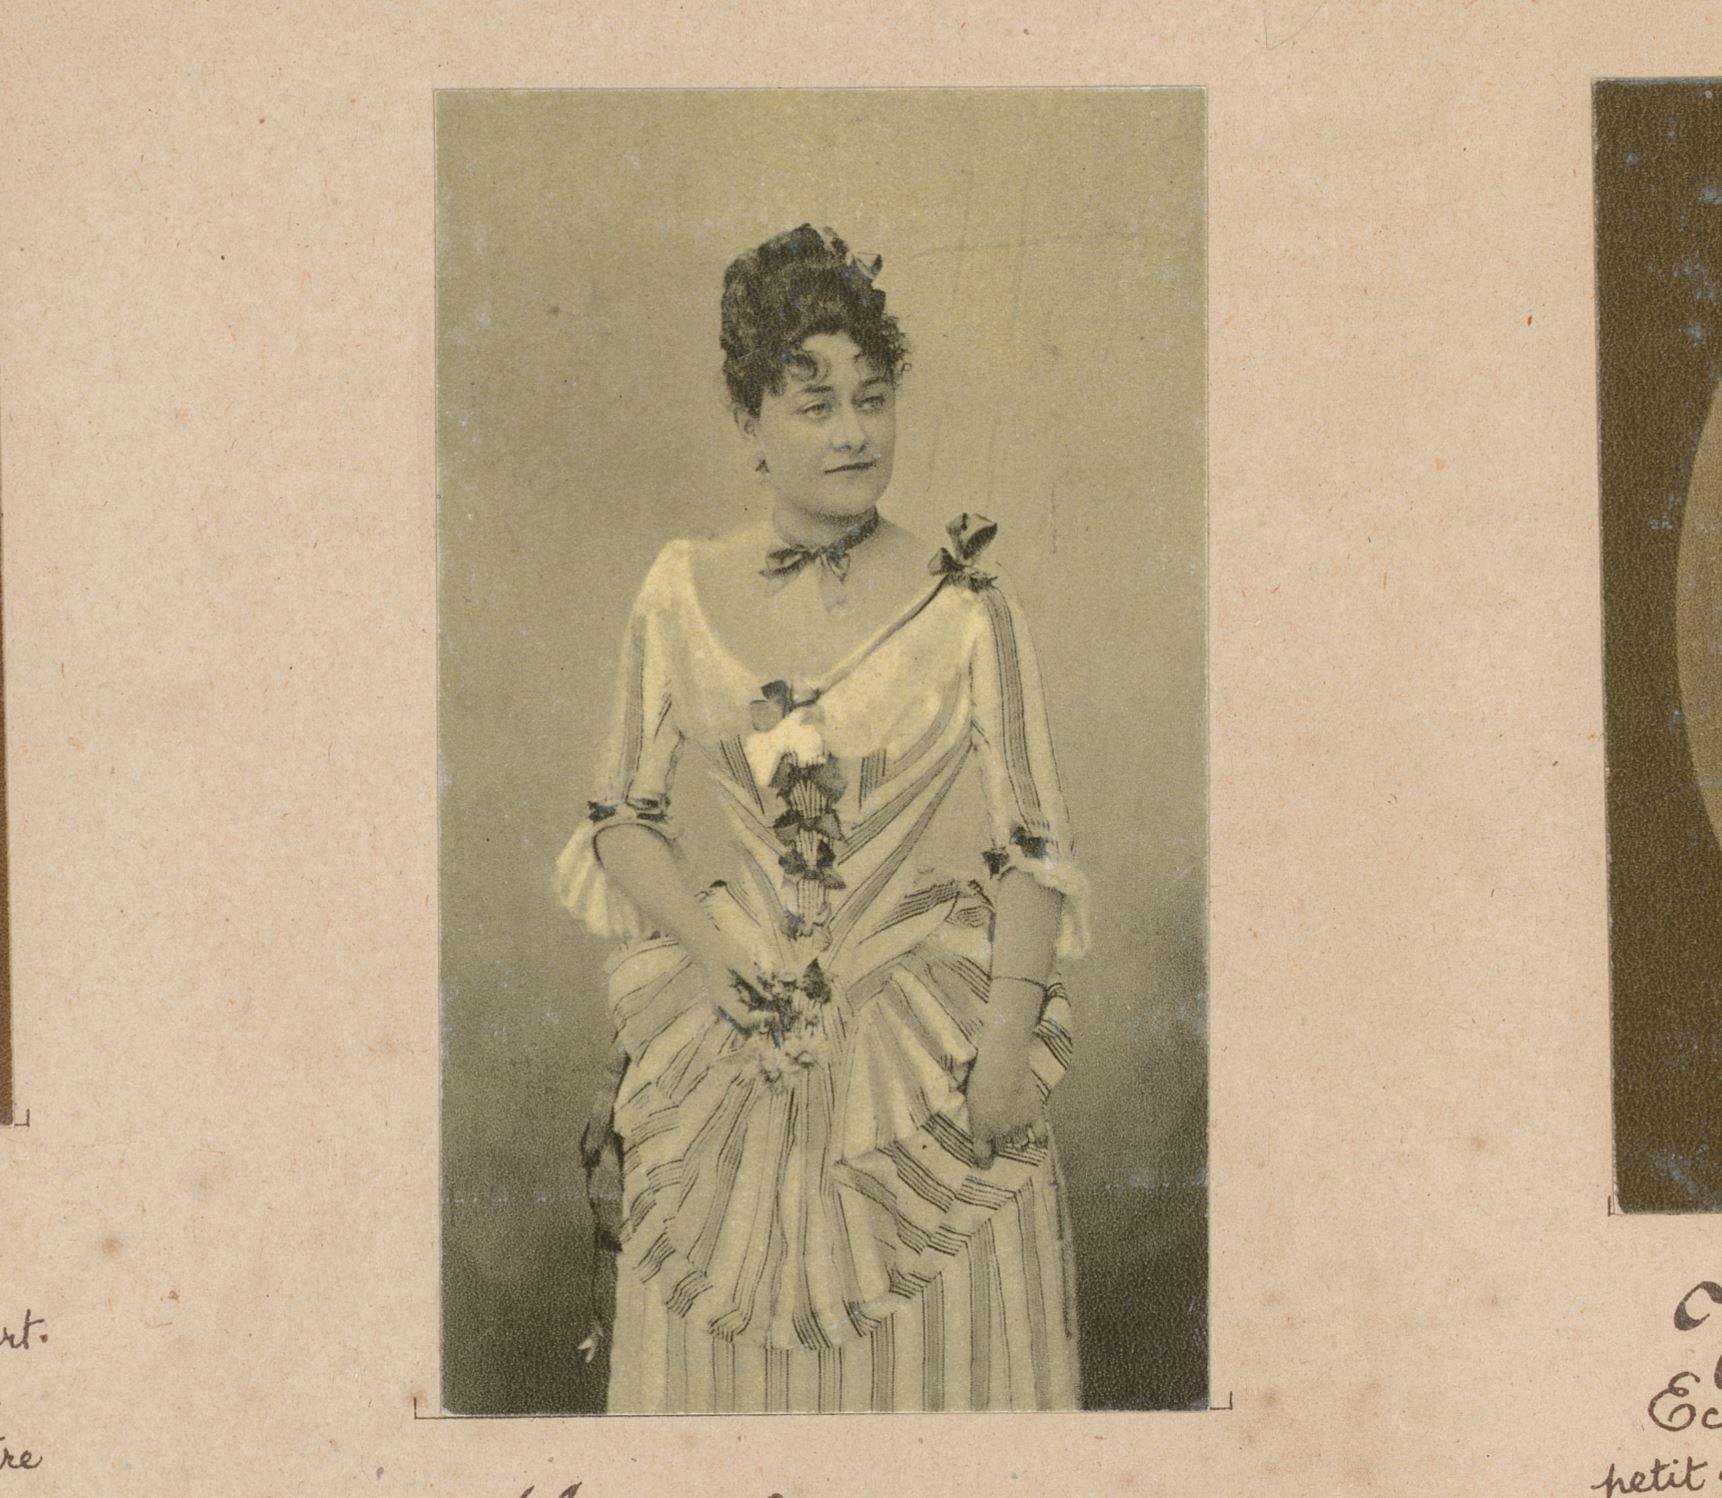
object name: album leaf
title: Portret van Marie Grisier-Montbazon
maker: Anonymous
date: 1877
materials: paper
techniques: rotogravure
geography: france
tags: portrait of actor, actress, france